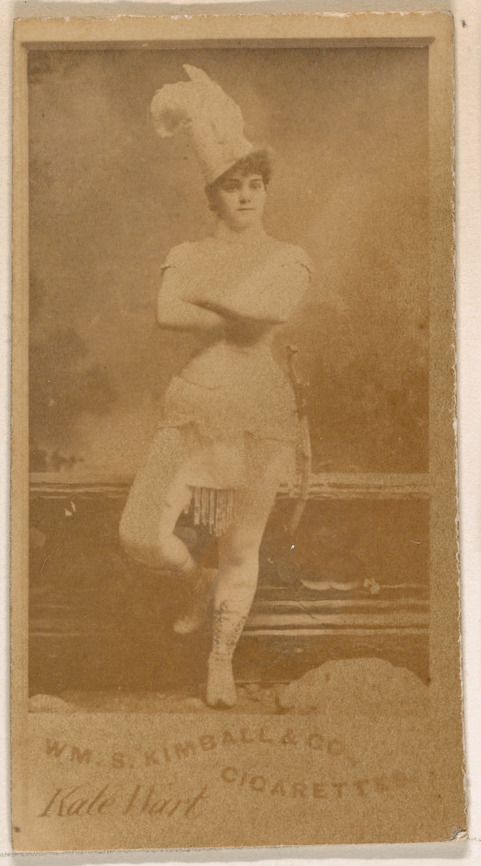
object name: photograph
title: Kate Wart, from the Actresses series (N203) issued by Wm. S. Kimball & Co.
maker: william s. kimball & company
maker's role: publisher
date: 1889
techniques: color lithograph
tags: portraits,women,actresses